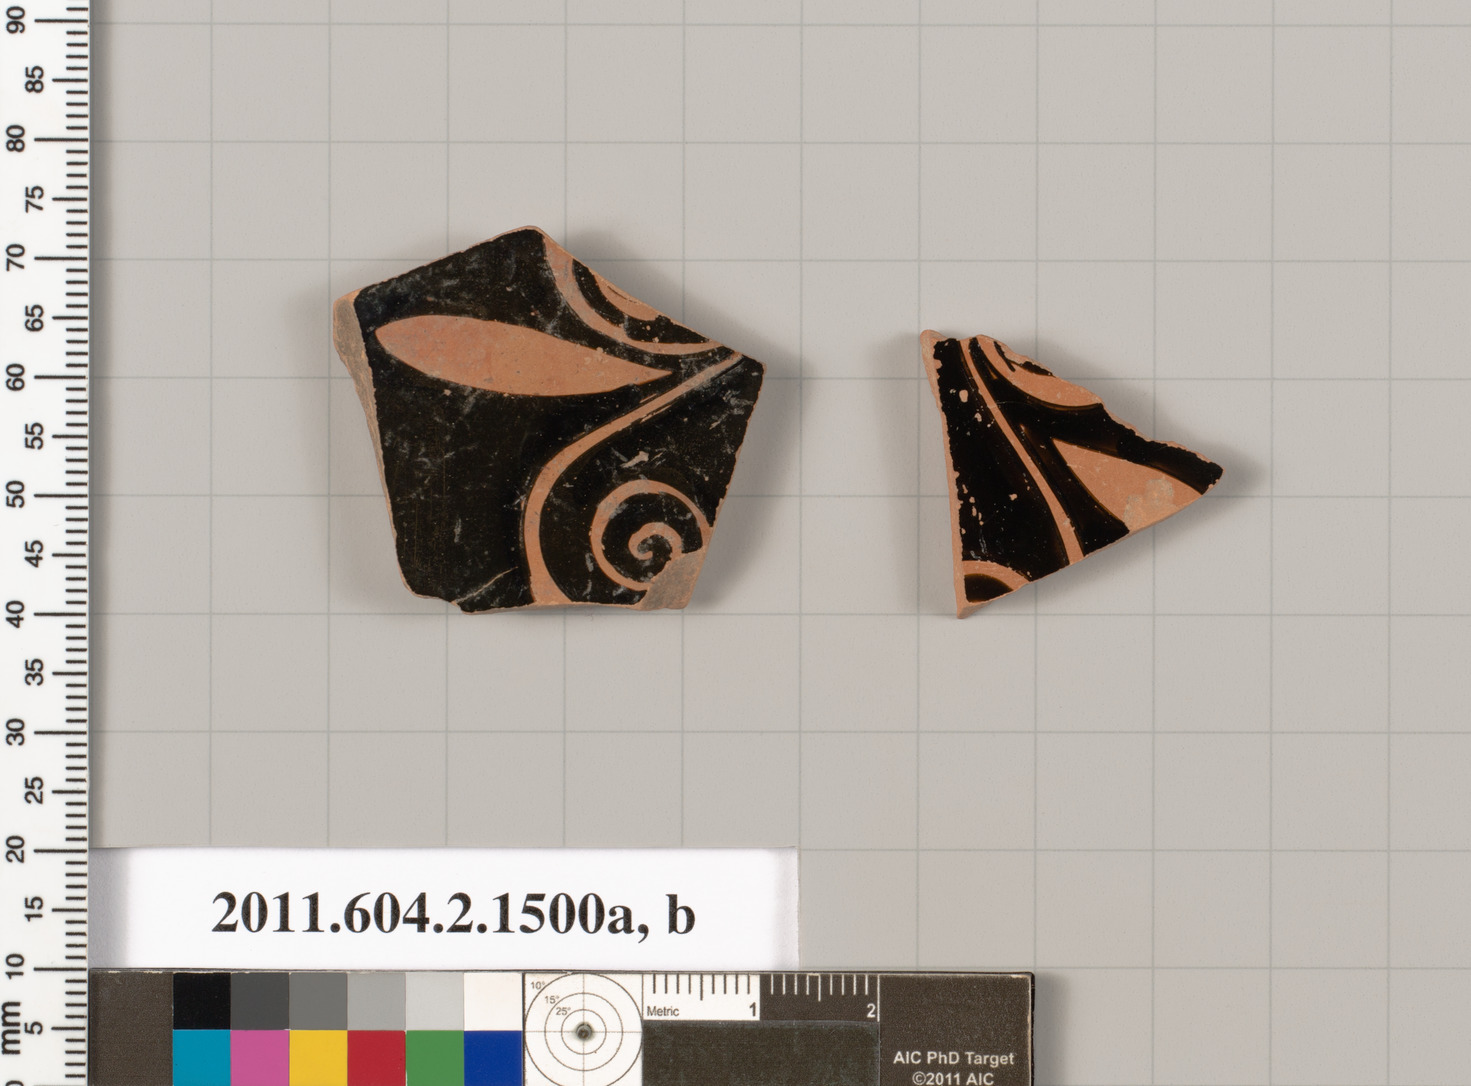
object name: skyphos fragment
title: Terracotta fragments of skyphoi (deep drinking cups)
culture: greek, attic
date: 475-440 BCE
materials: terracotta